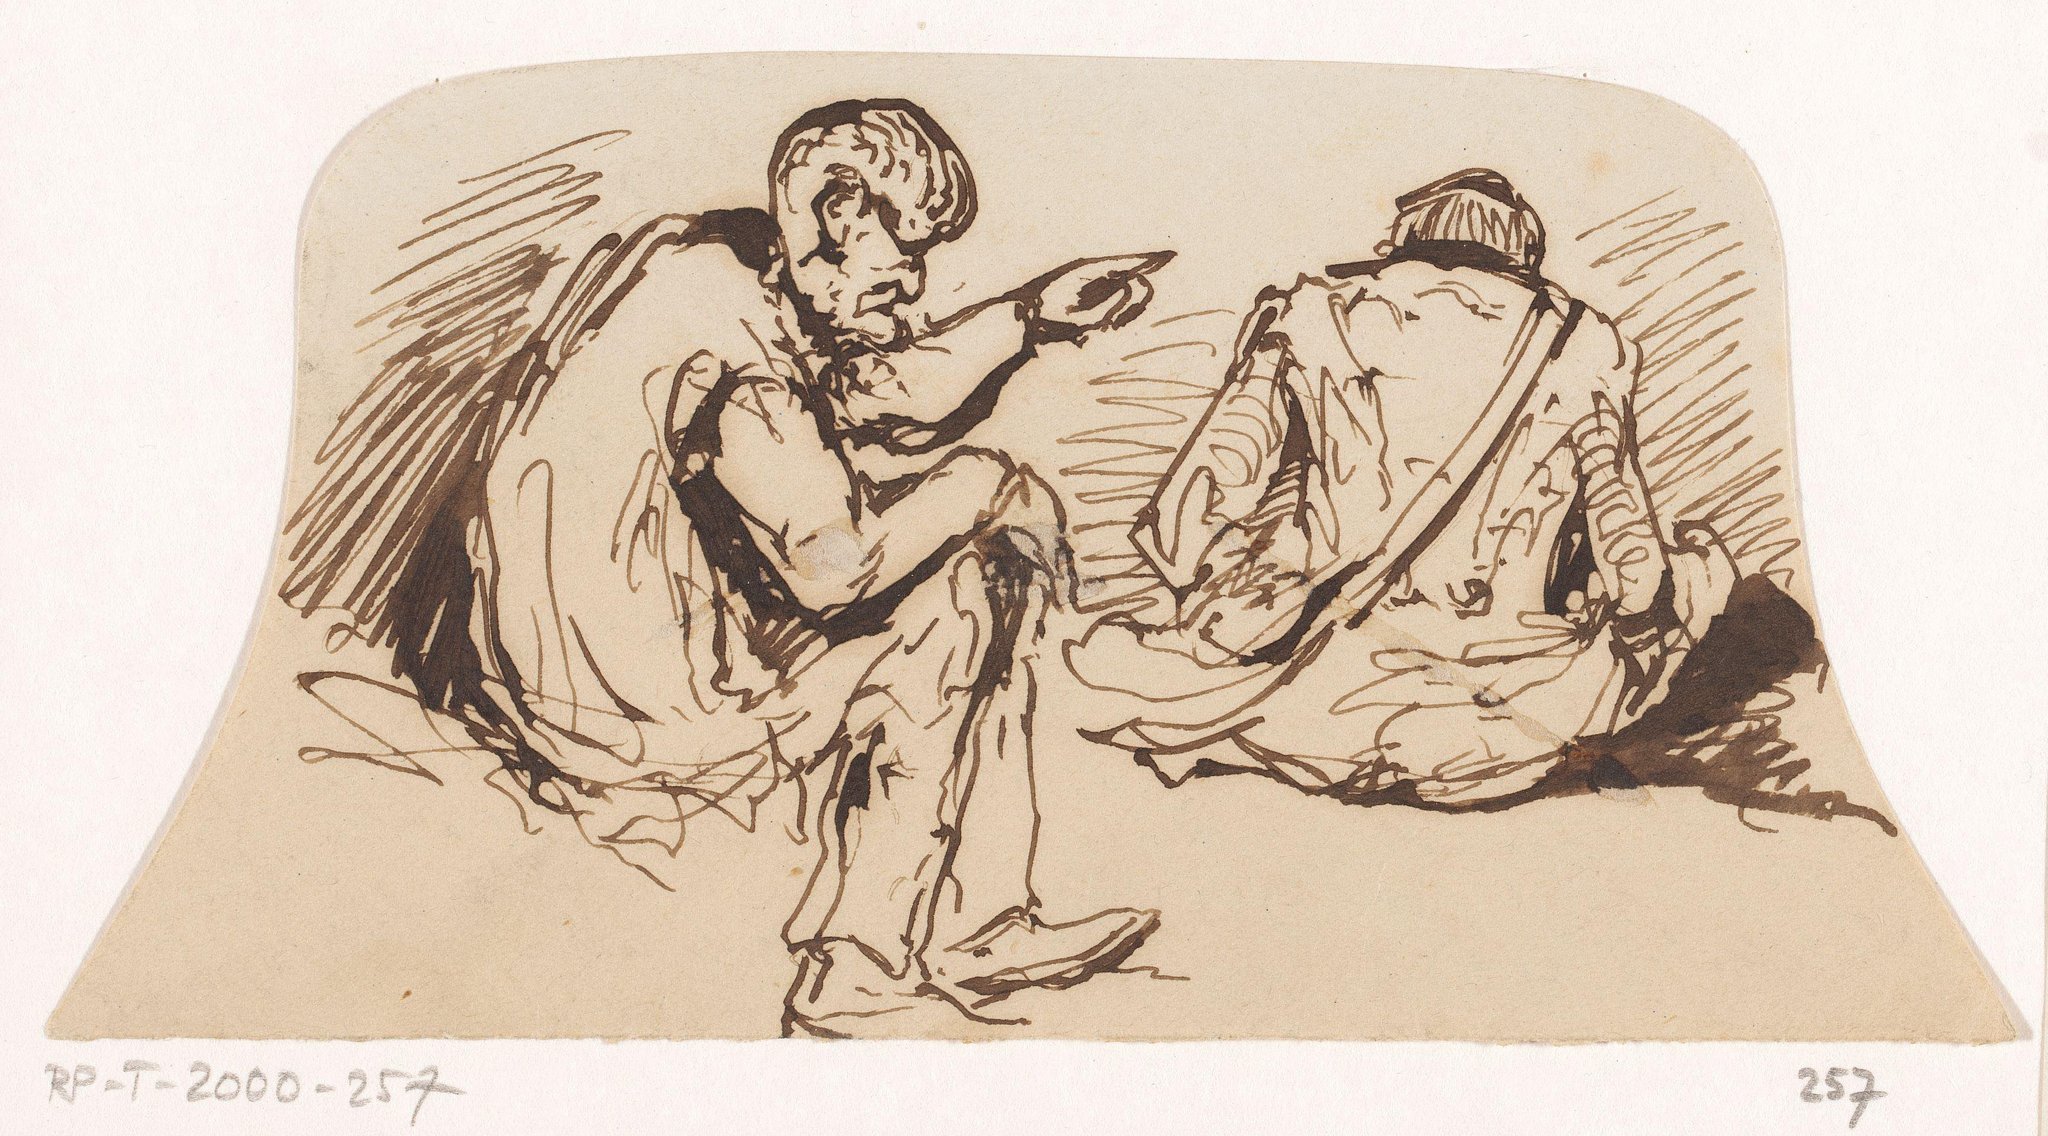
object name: drawing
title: Twee schetsen van een zittende man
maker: johannes tavenraat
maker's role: draughtsman, painter, print maker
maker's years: 1809-1881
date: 1840-1880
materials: ink, paper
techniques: pen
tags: sitting figure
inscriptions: collector's mark: Lugt 2228